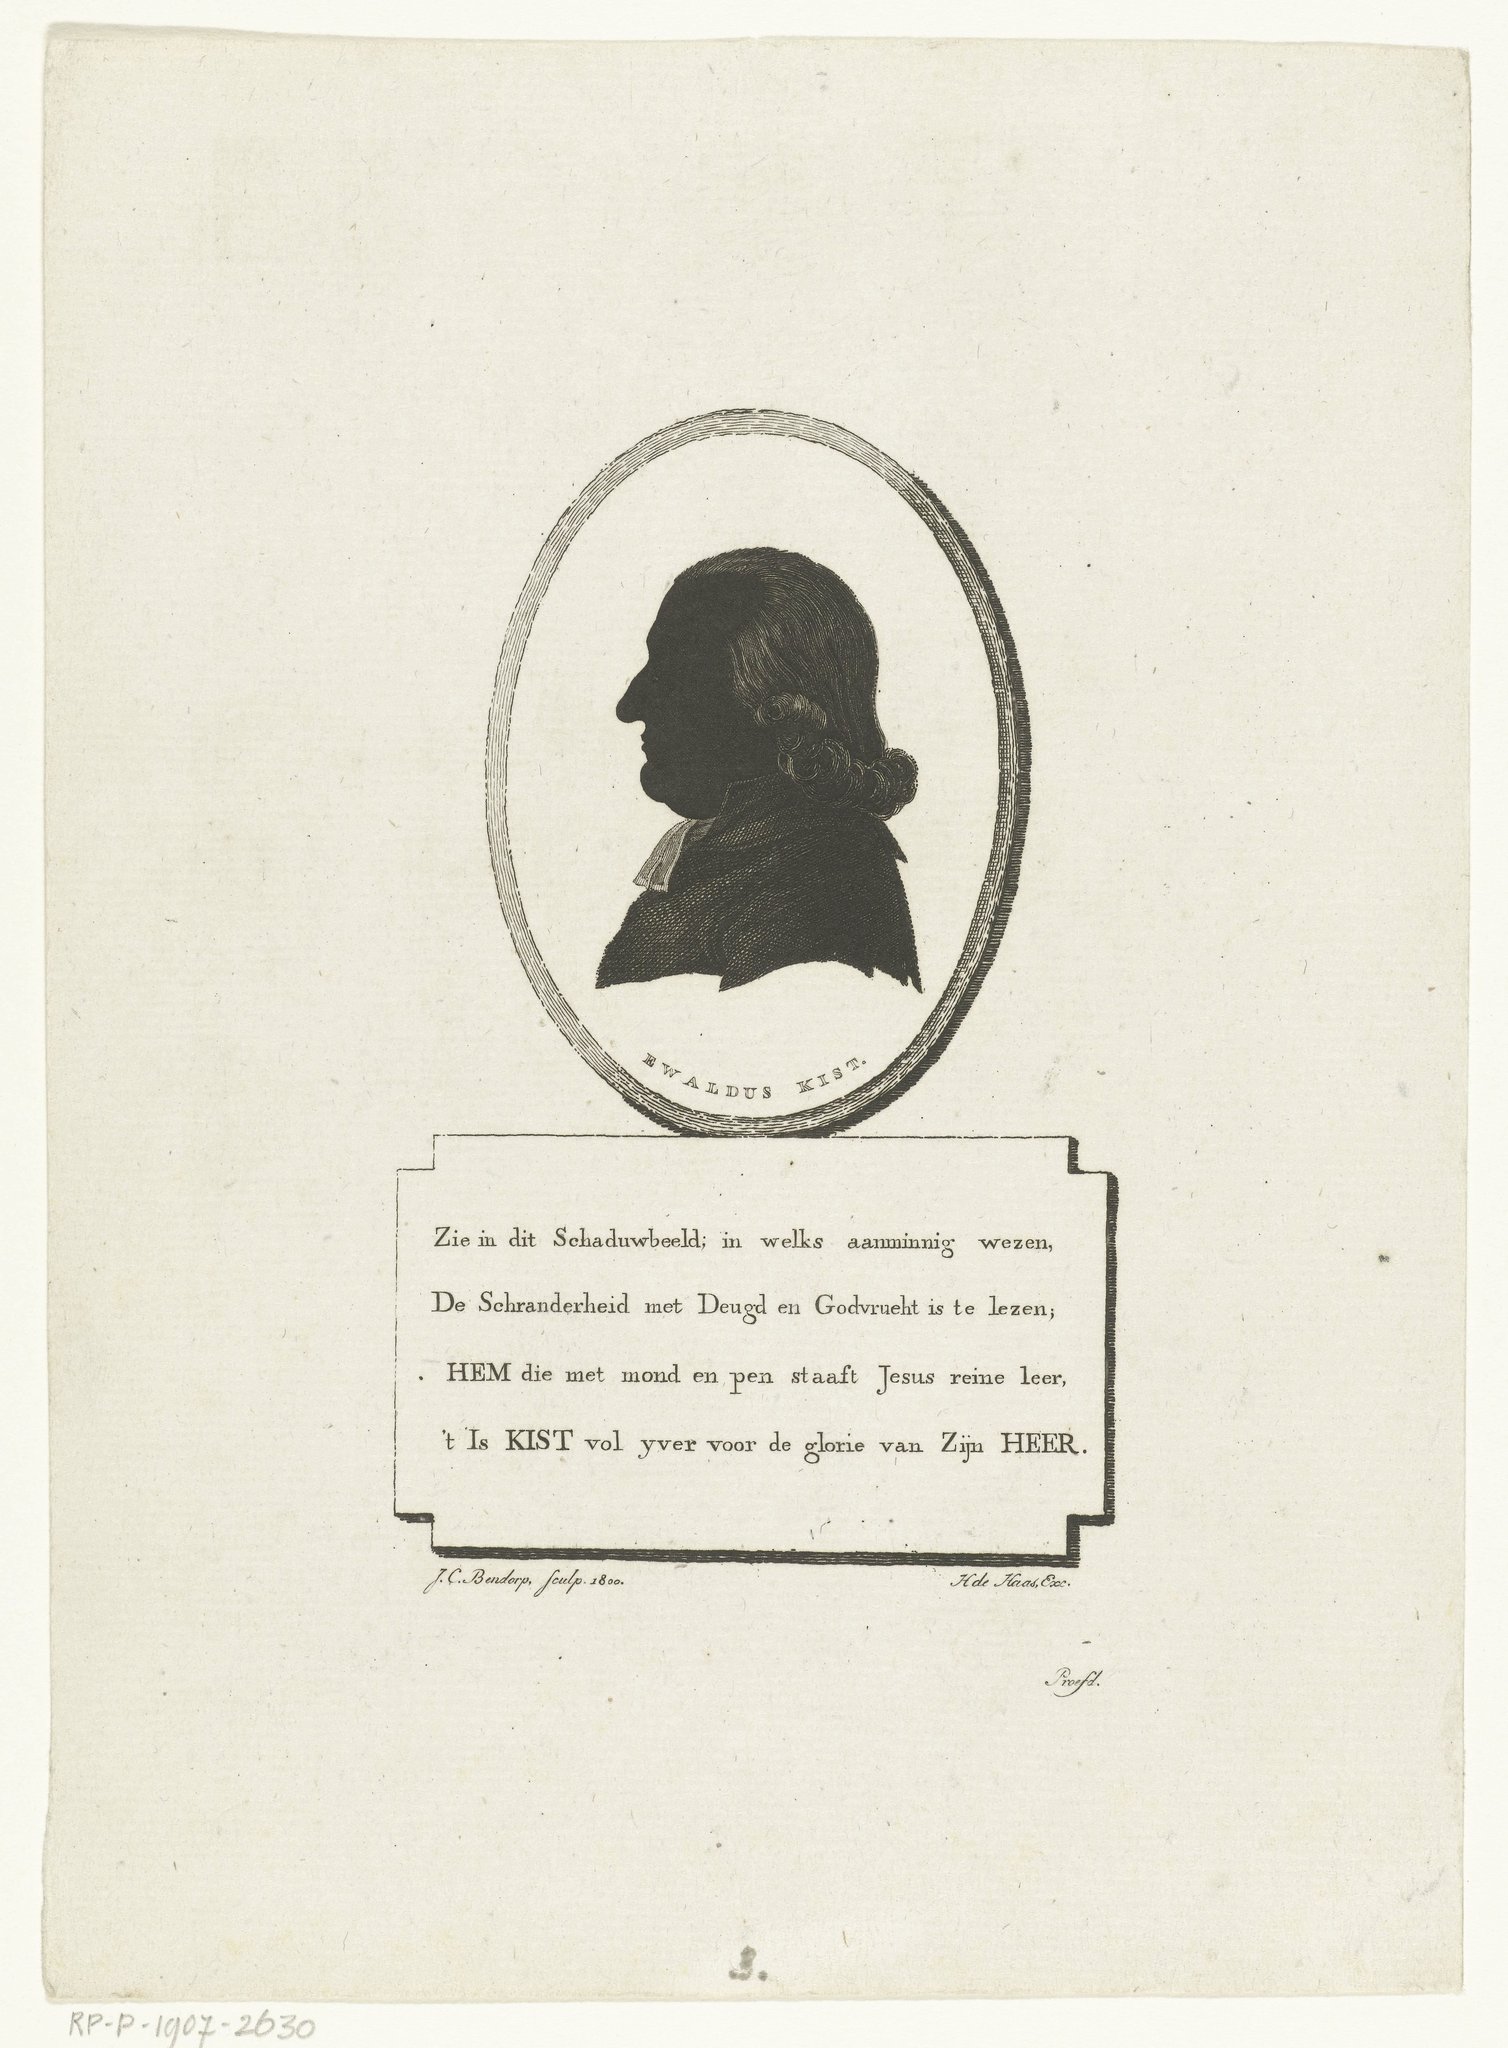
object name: print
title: Ewaldus Kist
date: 1800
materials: paper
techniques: etching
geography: netherlands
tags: functionaries and dignitaries (with name) ~ episcopal protestant churches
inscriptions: collector's mark: Lugt 2228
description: Portret in silhouet van predikant Ewald Kist in ovaal kader met onder voorstelling op tablet lofdicht in vier regels over de toewijding aan zijn vak.